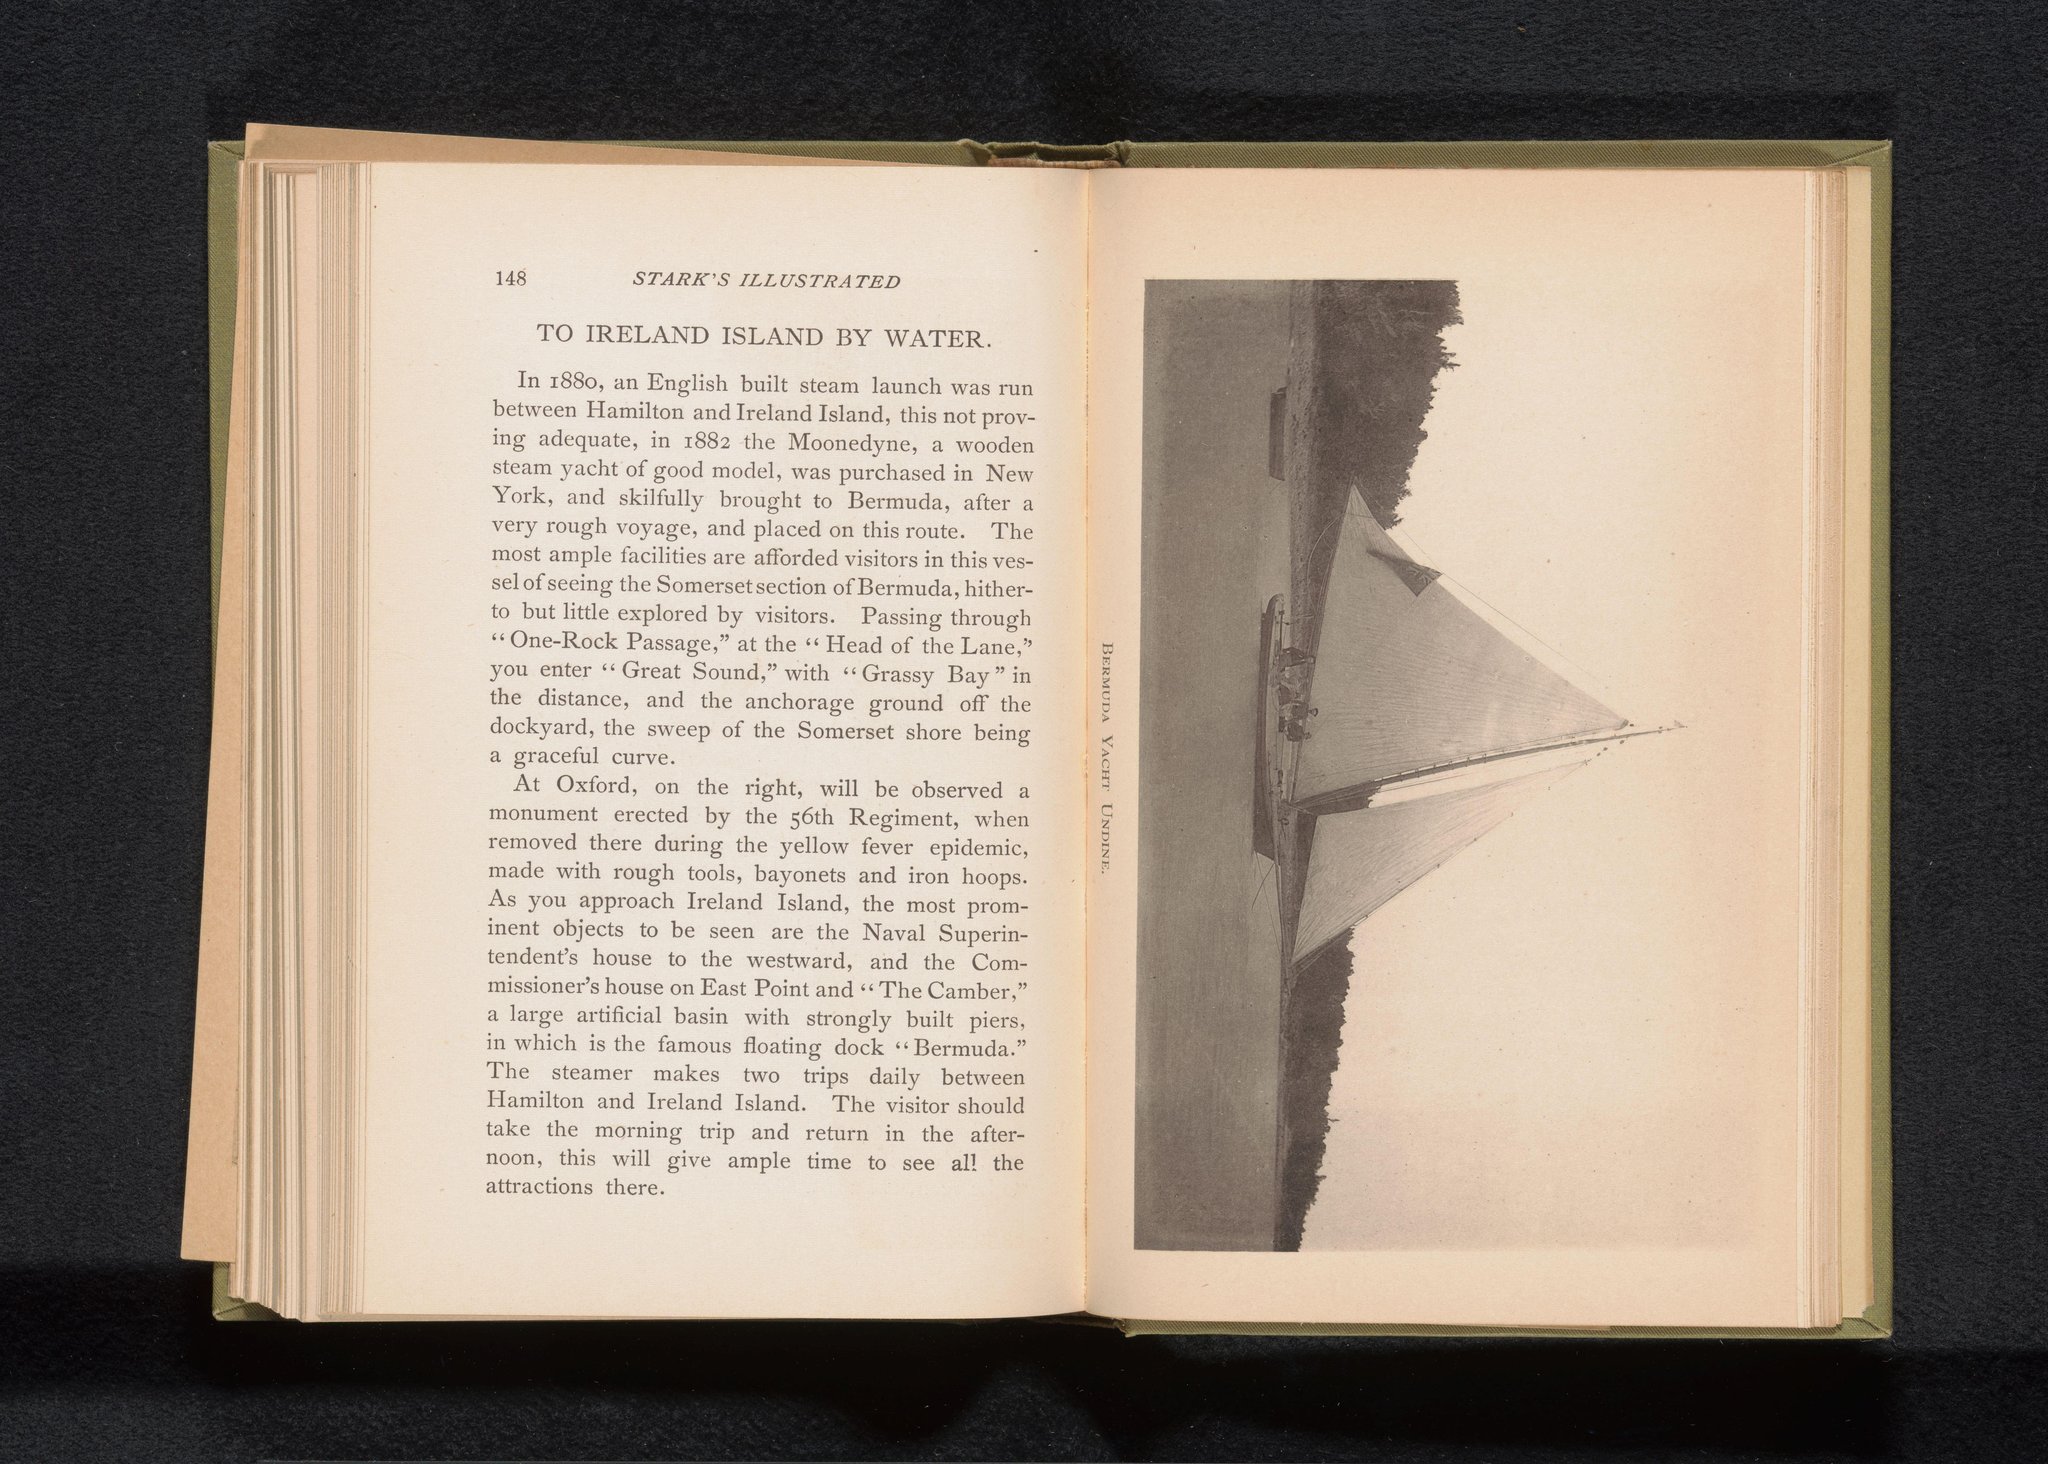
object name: page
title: Bermuda yacht Undine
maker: james h. stark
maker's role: fotograaf, schrijver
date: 1879-1884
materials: paper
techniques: photograph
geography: bermuda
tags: ships (in general)